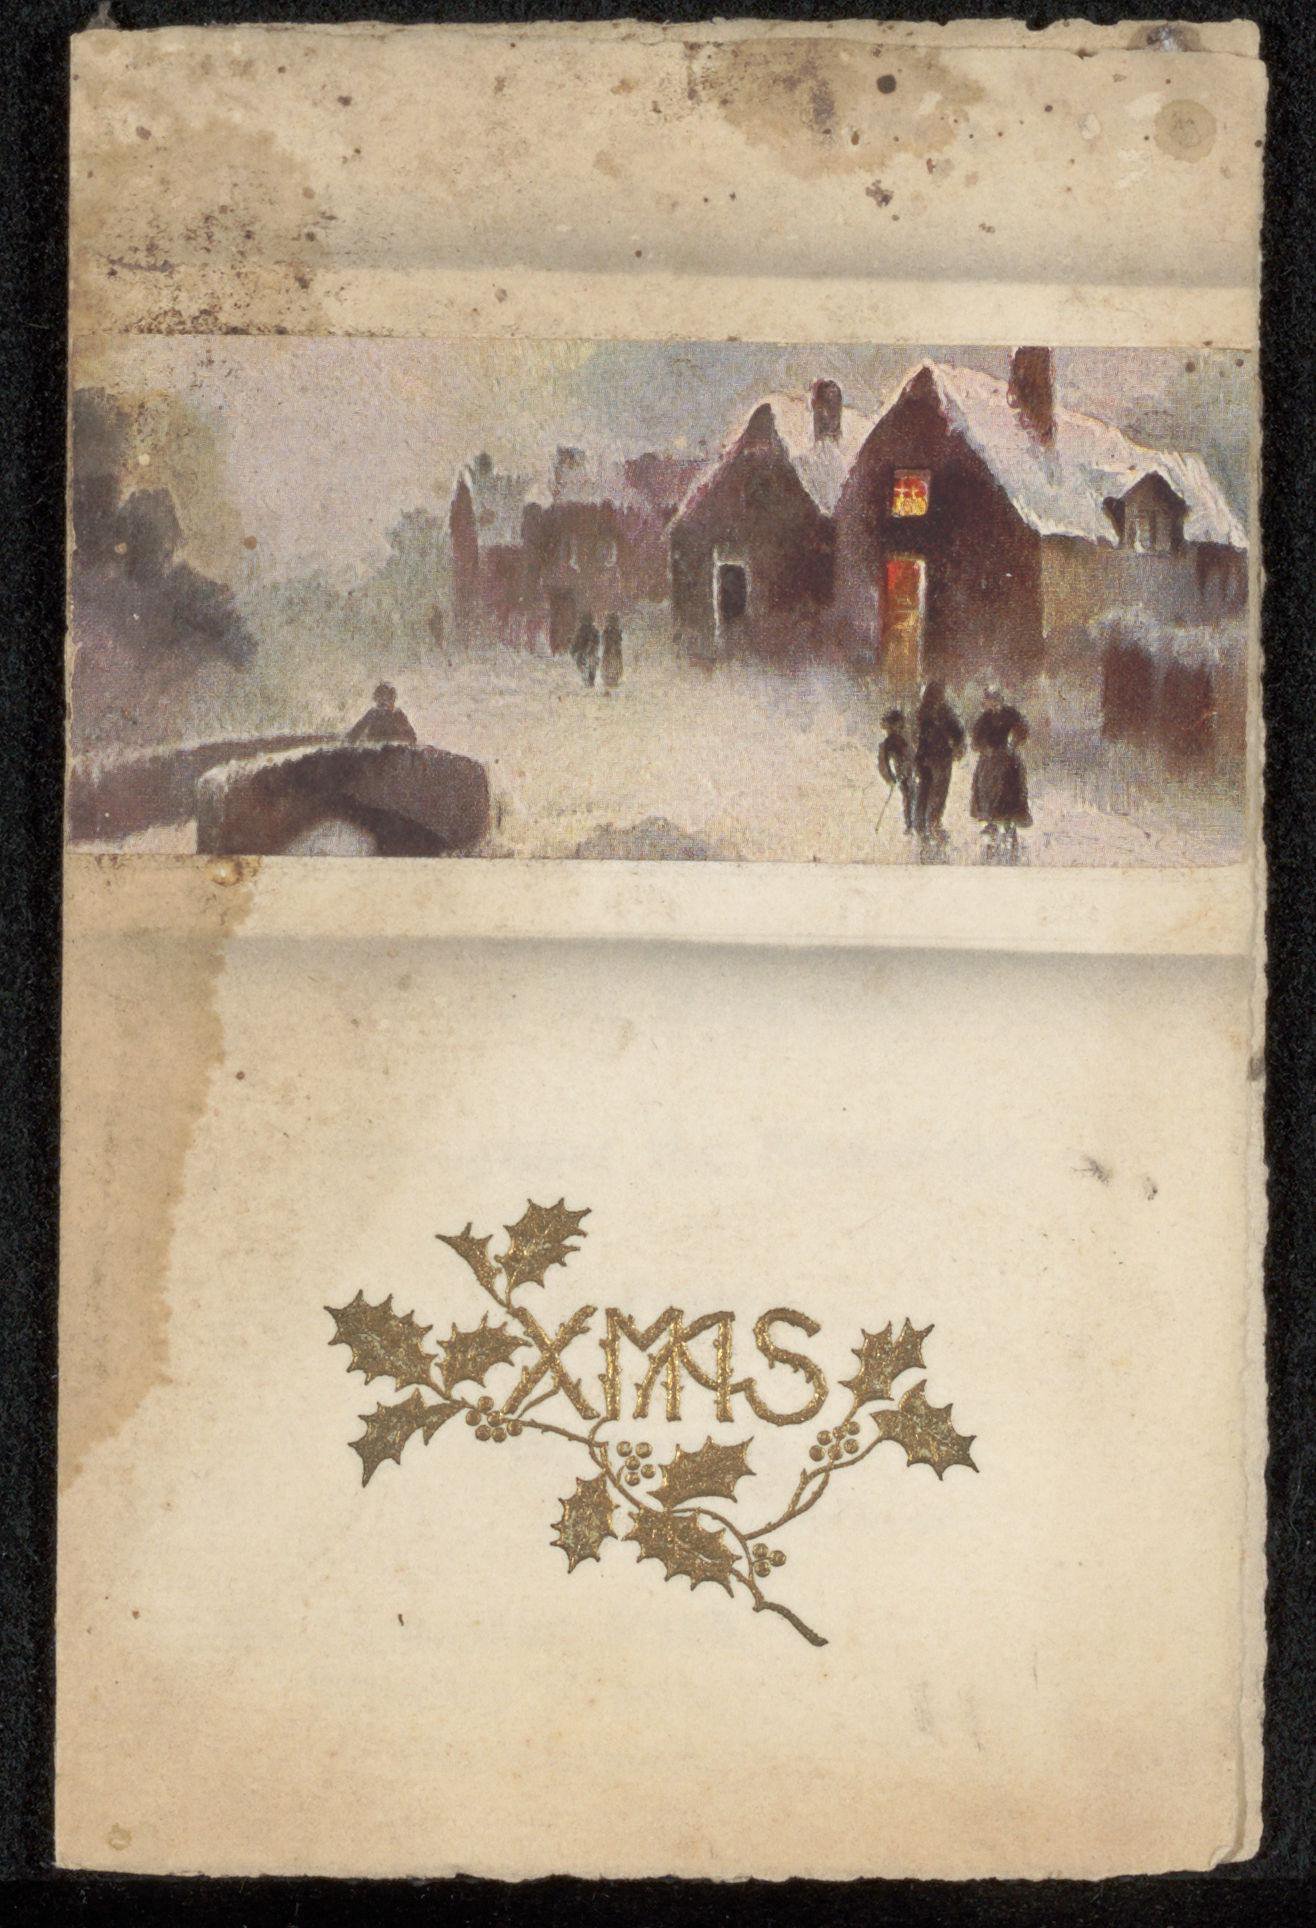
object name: letter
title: Brief aan Philip Zilcken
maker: w. cownie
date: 1867-1930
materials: ink, paper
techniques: pen, printing, relief print, writing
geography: manchester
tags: manchester, elsie maud cownie, painter, philip zilcken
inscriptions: collector's mark: ‘RPK’